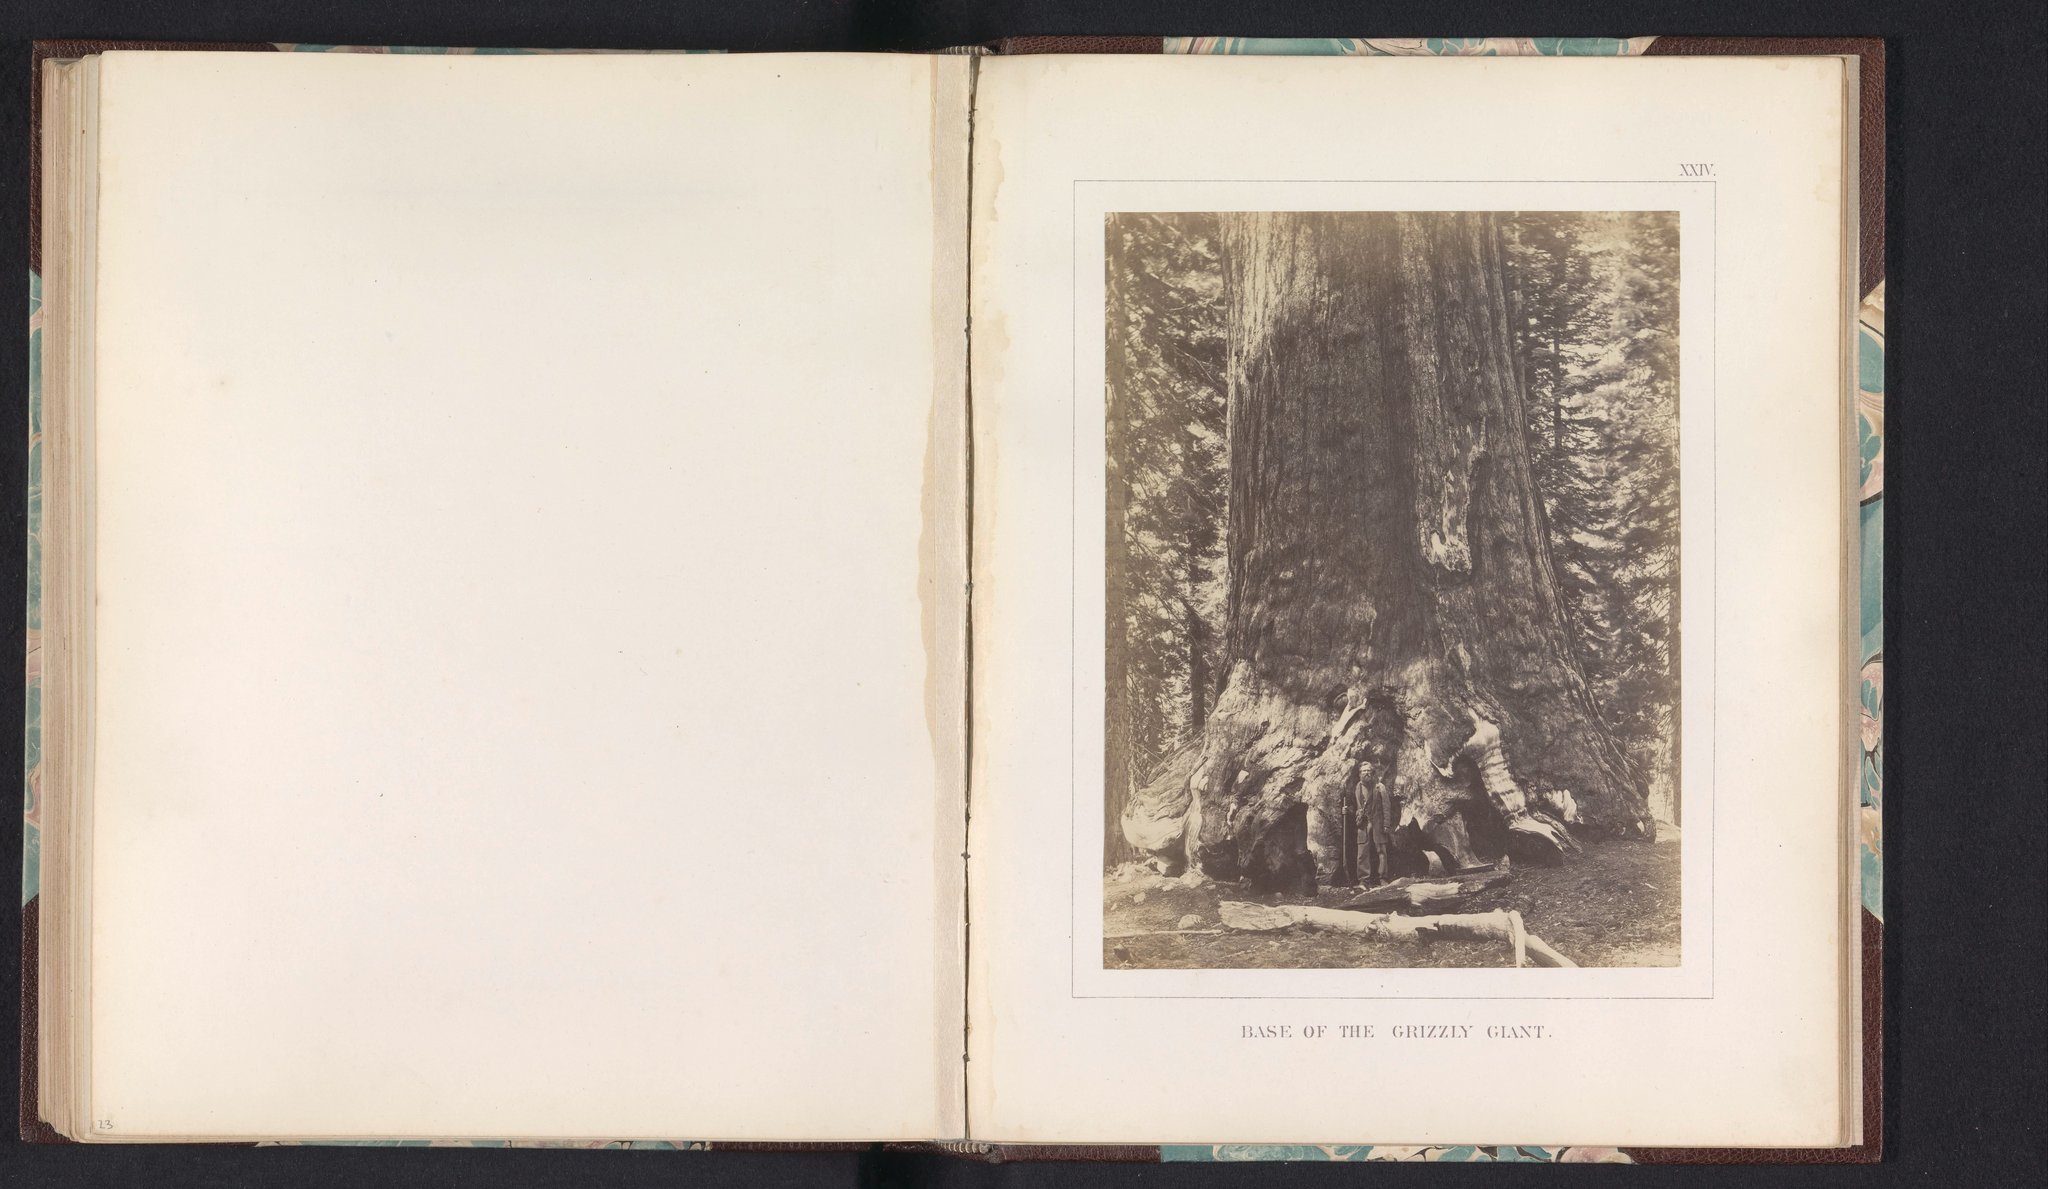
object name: page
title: Base of the Grizzly Giant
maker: carleton e. watkins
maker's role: fotograaf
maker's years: 1829-1916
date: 1860-1868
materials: photographic support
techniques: albumen print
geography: mariposa grove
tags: fabulous trees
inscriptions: number: ‘XXIV.’